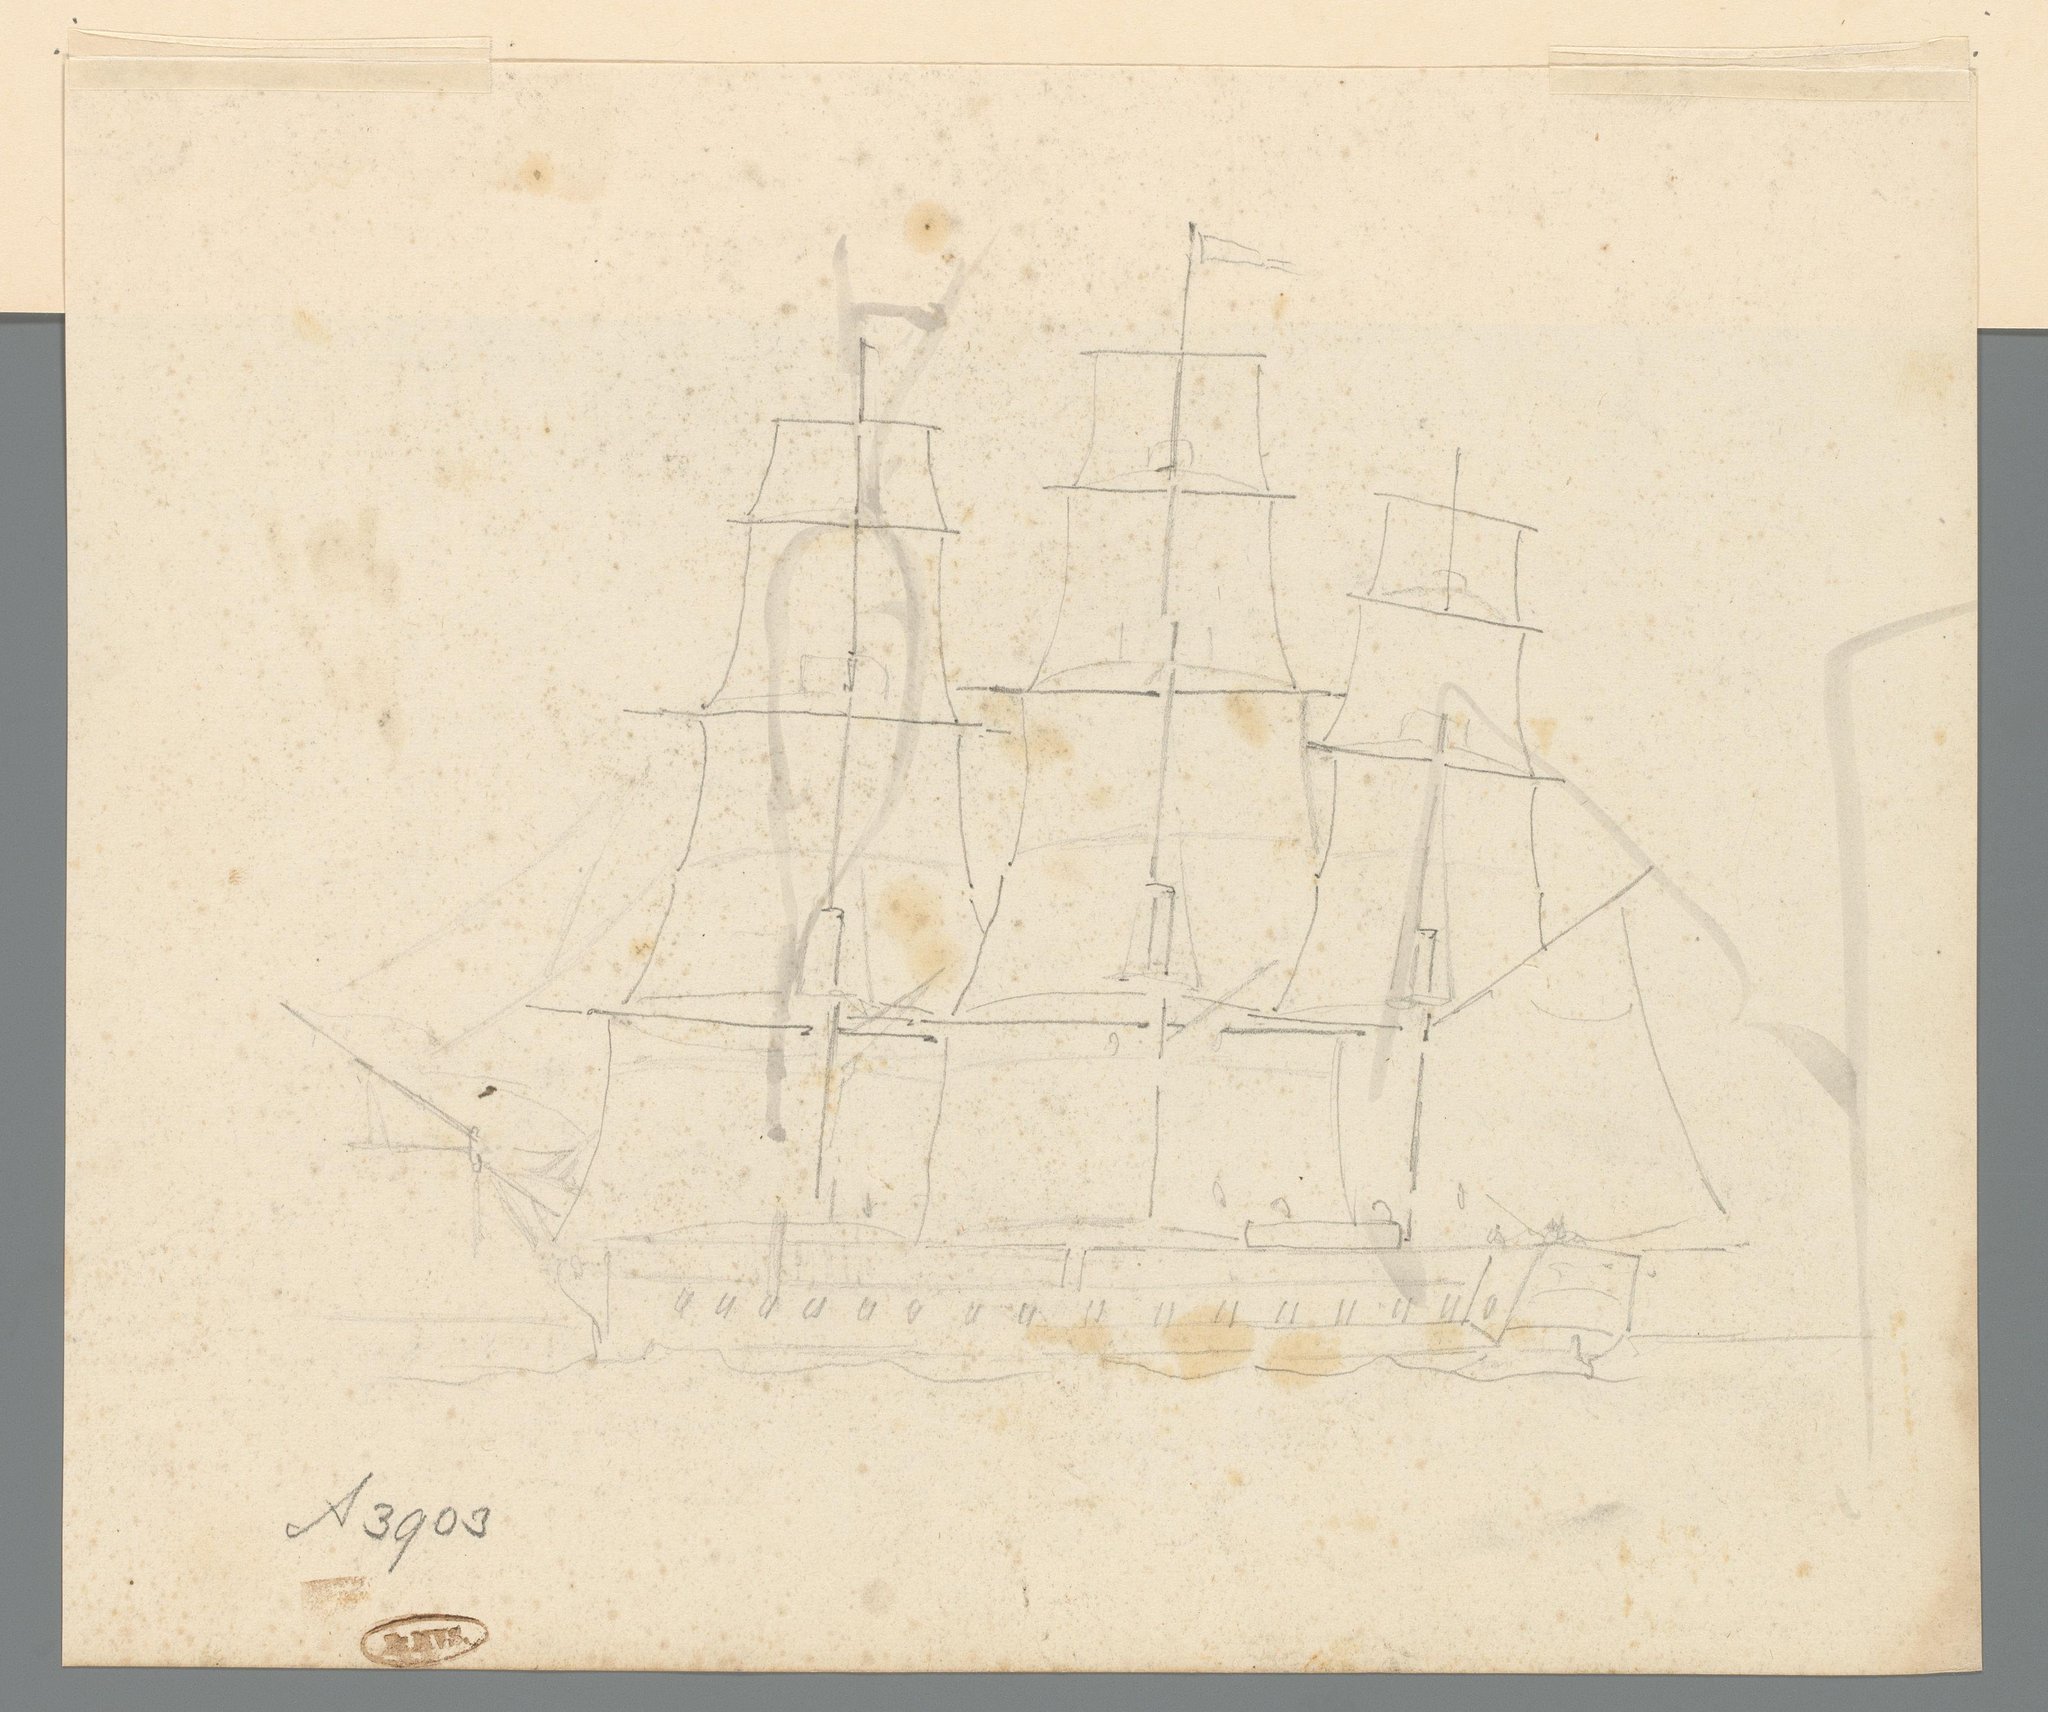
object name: drawing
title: Schets van een driemaster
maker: willem anthonie van deventer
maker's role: draughtsman, painter, print maker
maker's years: 1824-1893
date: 1834-1893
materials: paper, pencil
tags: sailing-ship, sailing-boat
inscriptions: date: ‘Octob.’